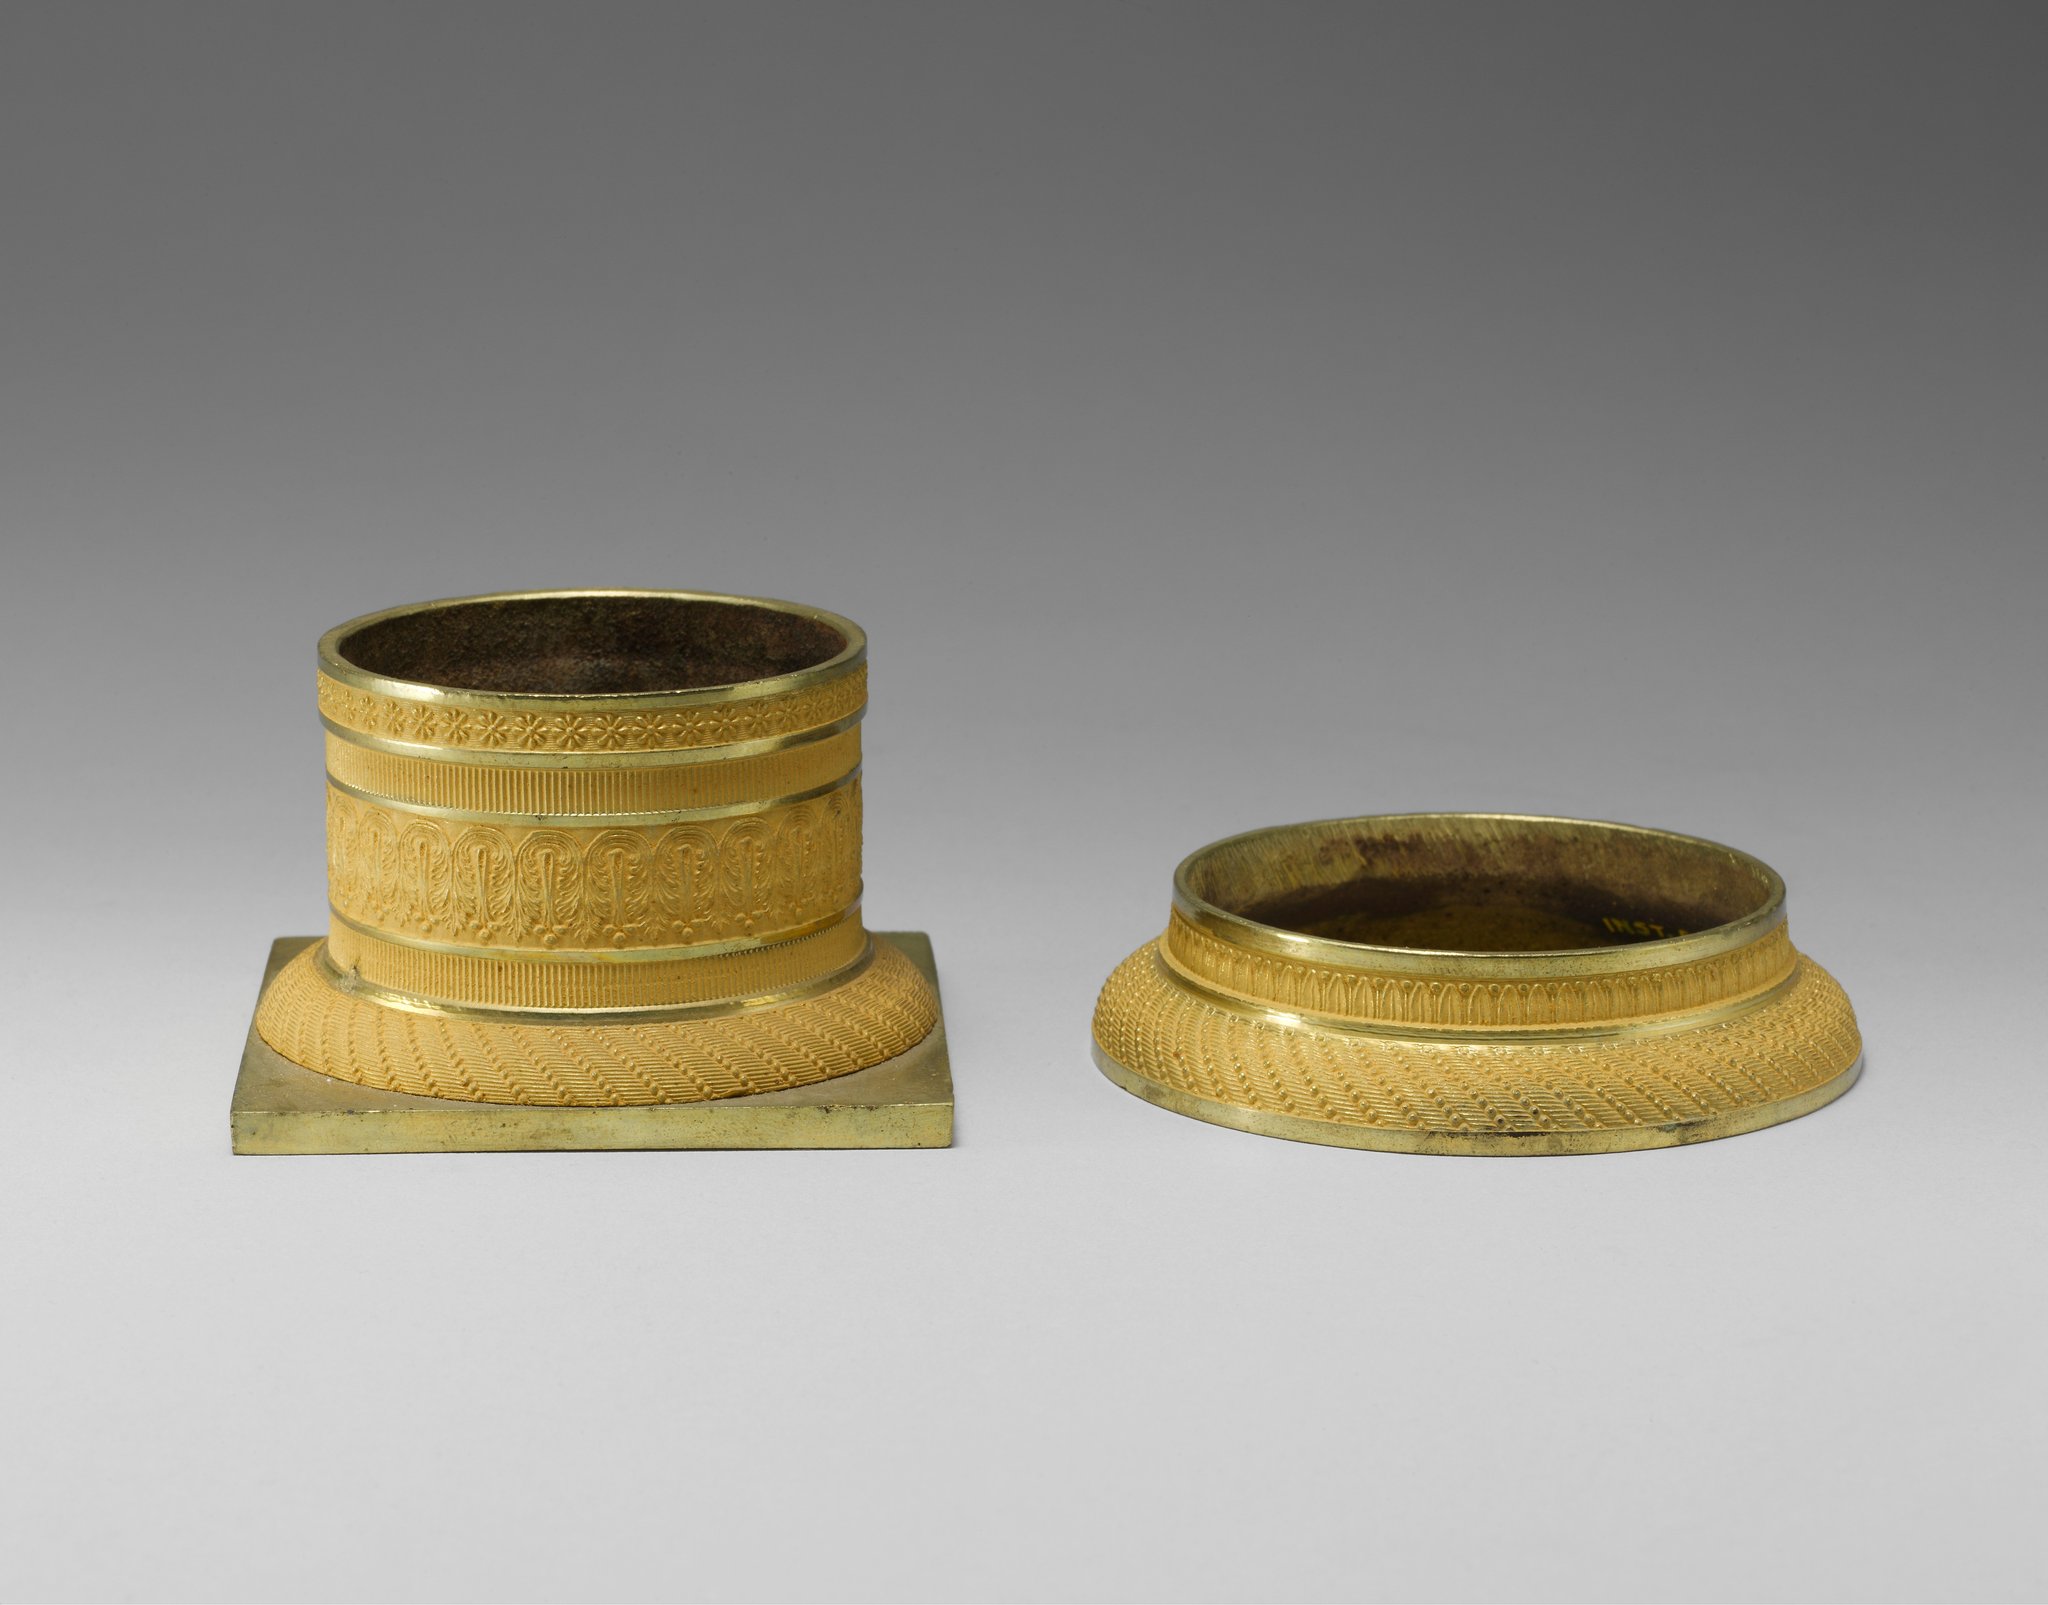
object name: column base and capital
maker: henry kellam hancock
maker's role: retailer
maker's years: 1816-1851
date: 1810-1830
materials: brass, gold, mercury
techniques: casting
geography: france